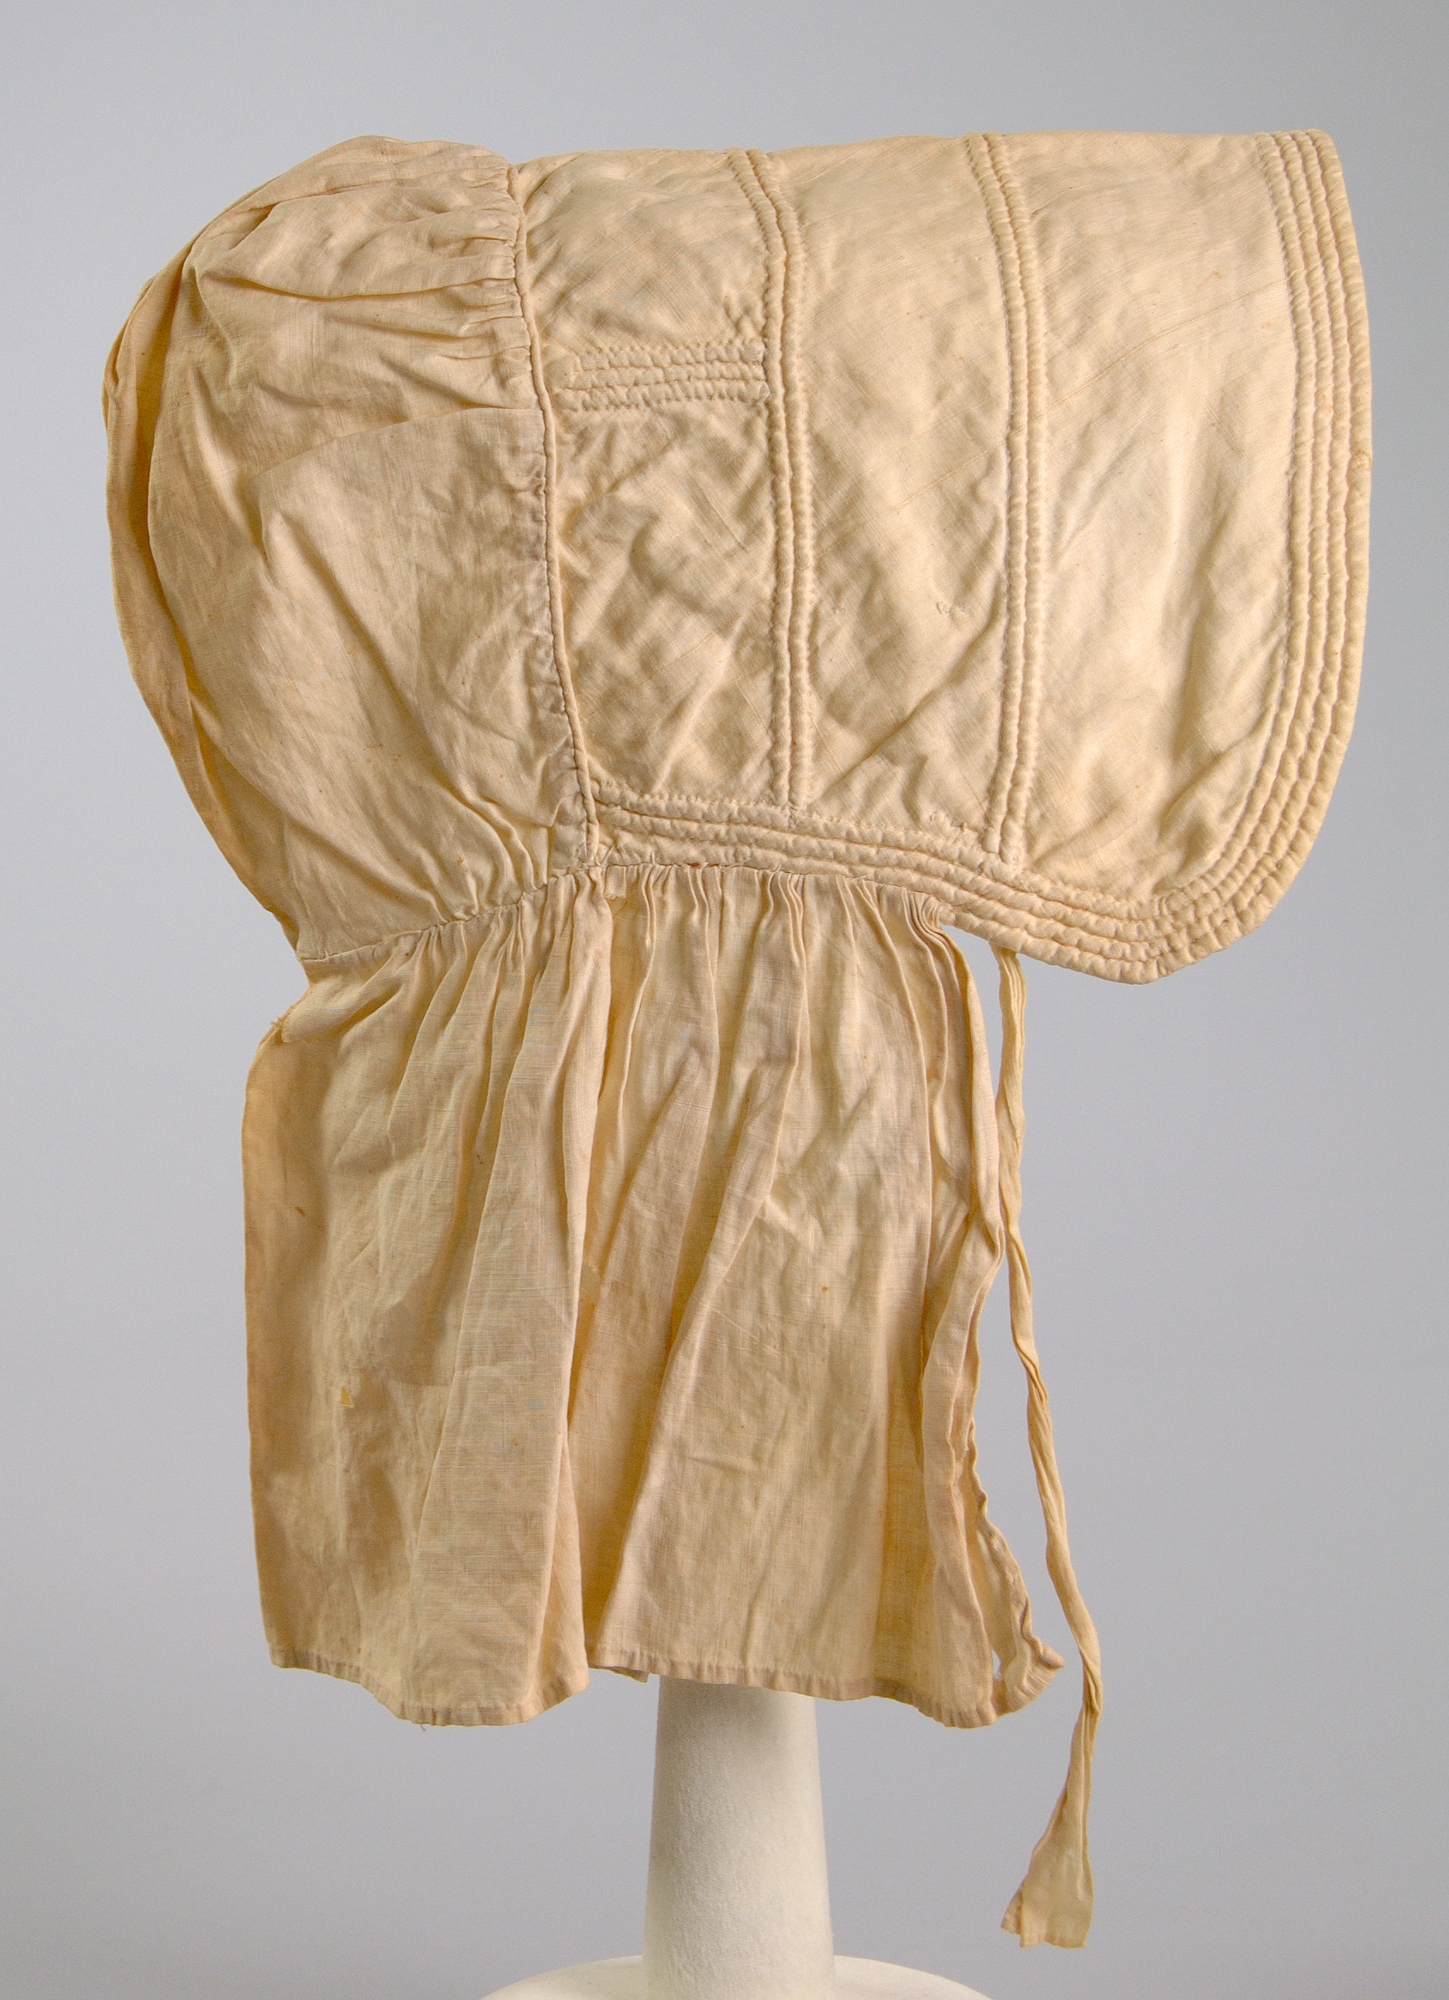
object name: sunbonnet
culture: american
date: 1840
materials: cotton